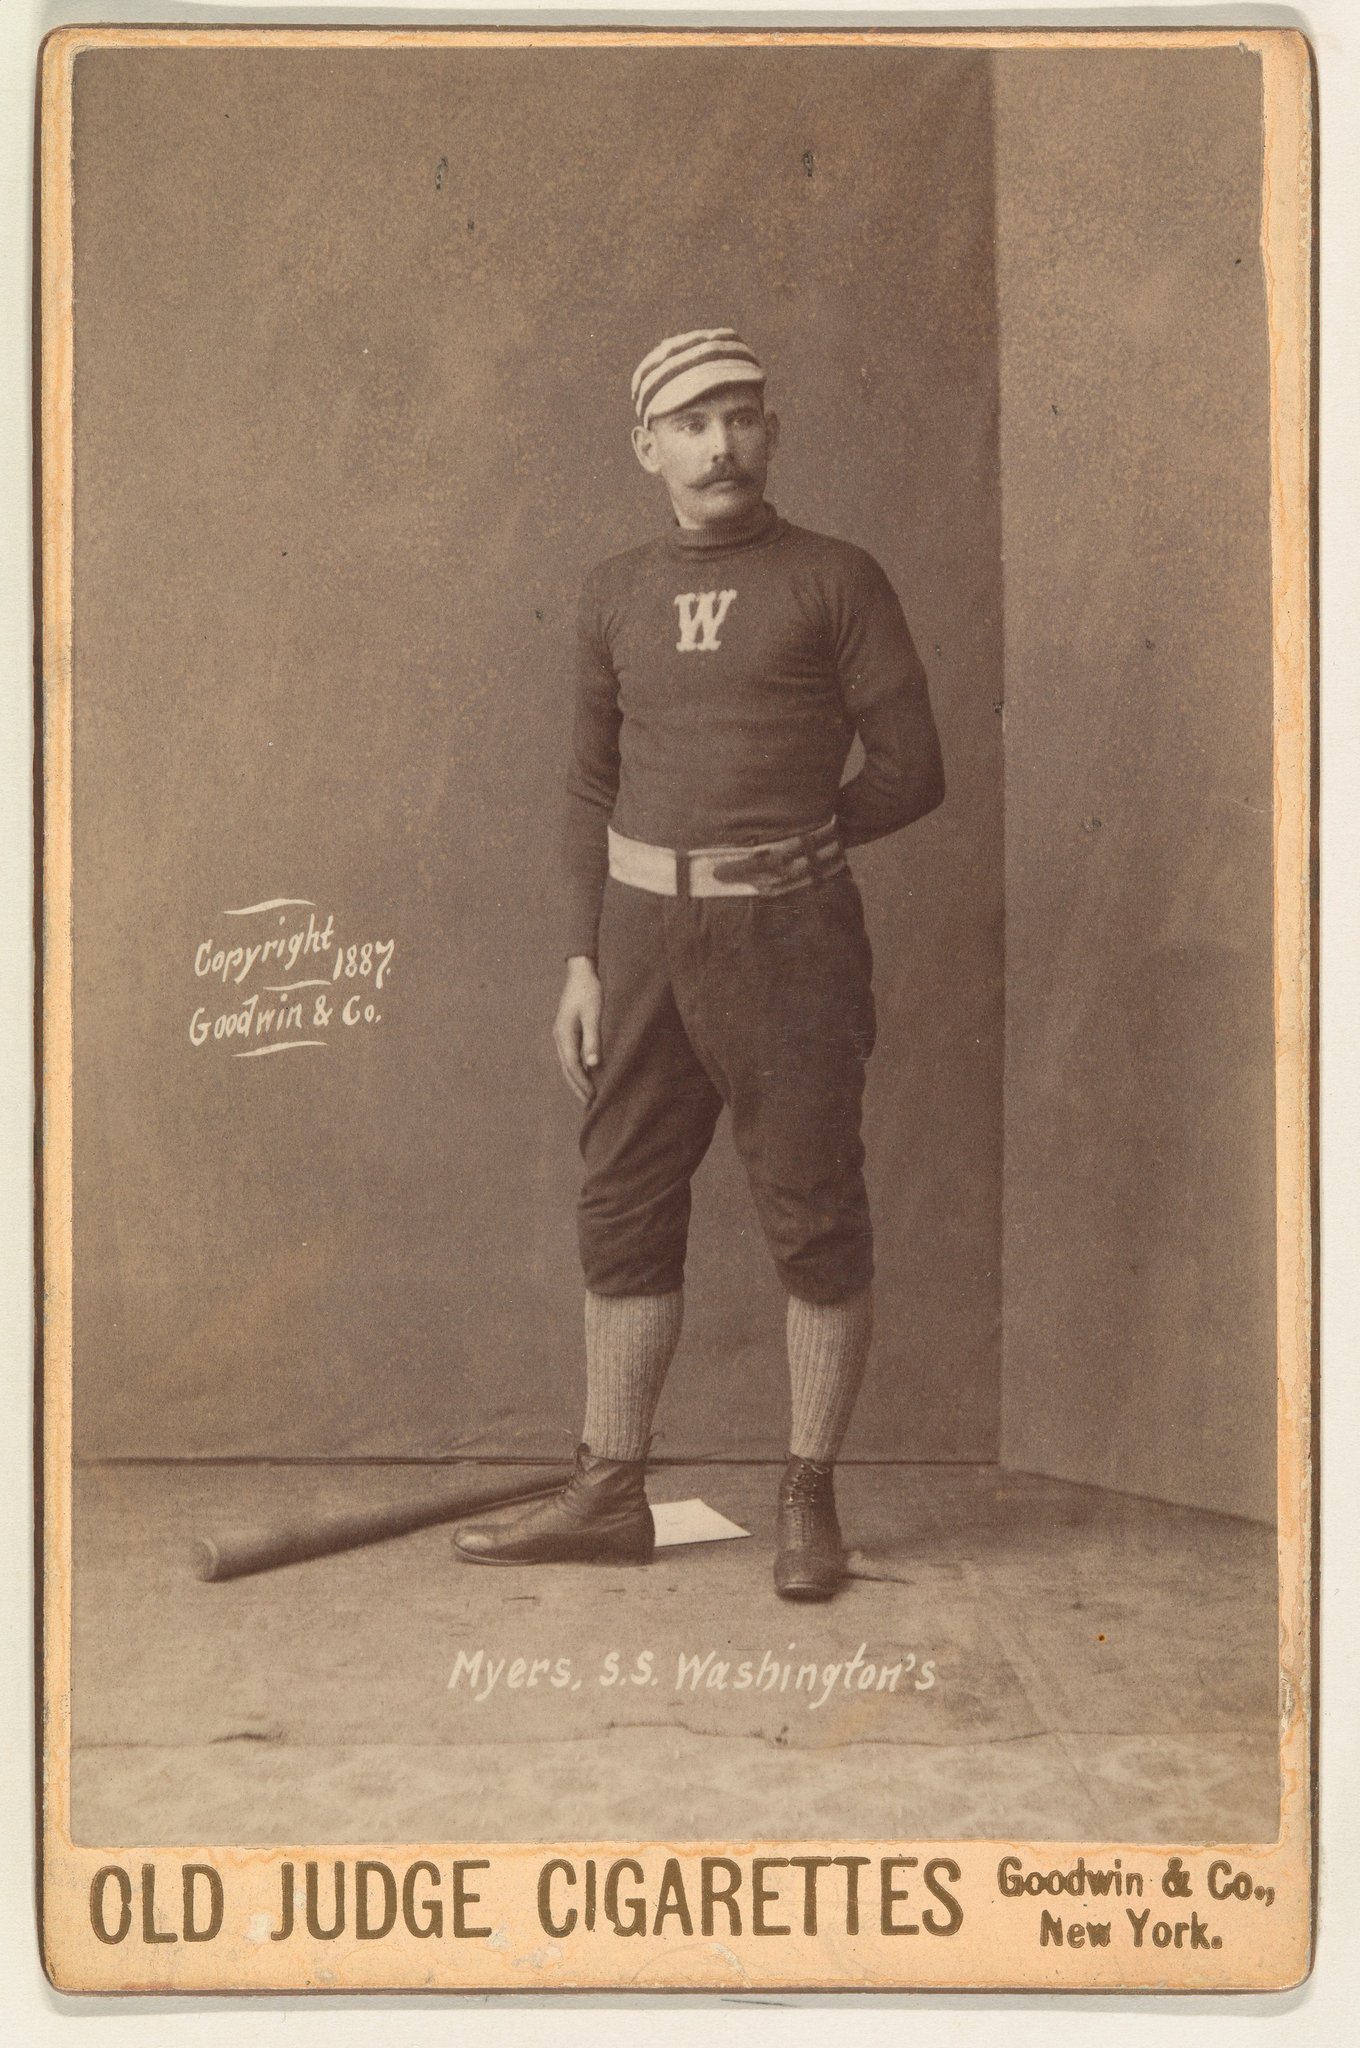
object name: baseball card, photograph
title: Myers, Shortstop, Washington, from the series Old Judge Cigarettes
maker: goodwin & company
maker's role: publisher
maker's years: 1850-1950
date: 1887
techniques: albumen print, photography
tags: men,portraits,baseball,athletes